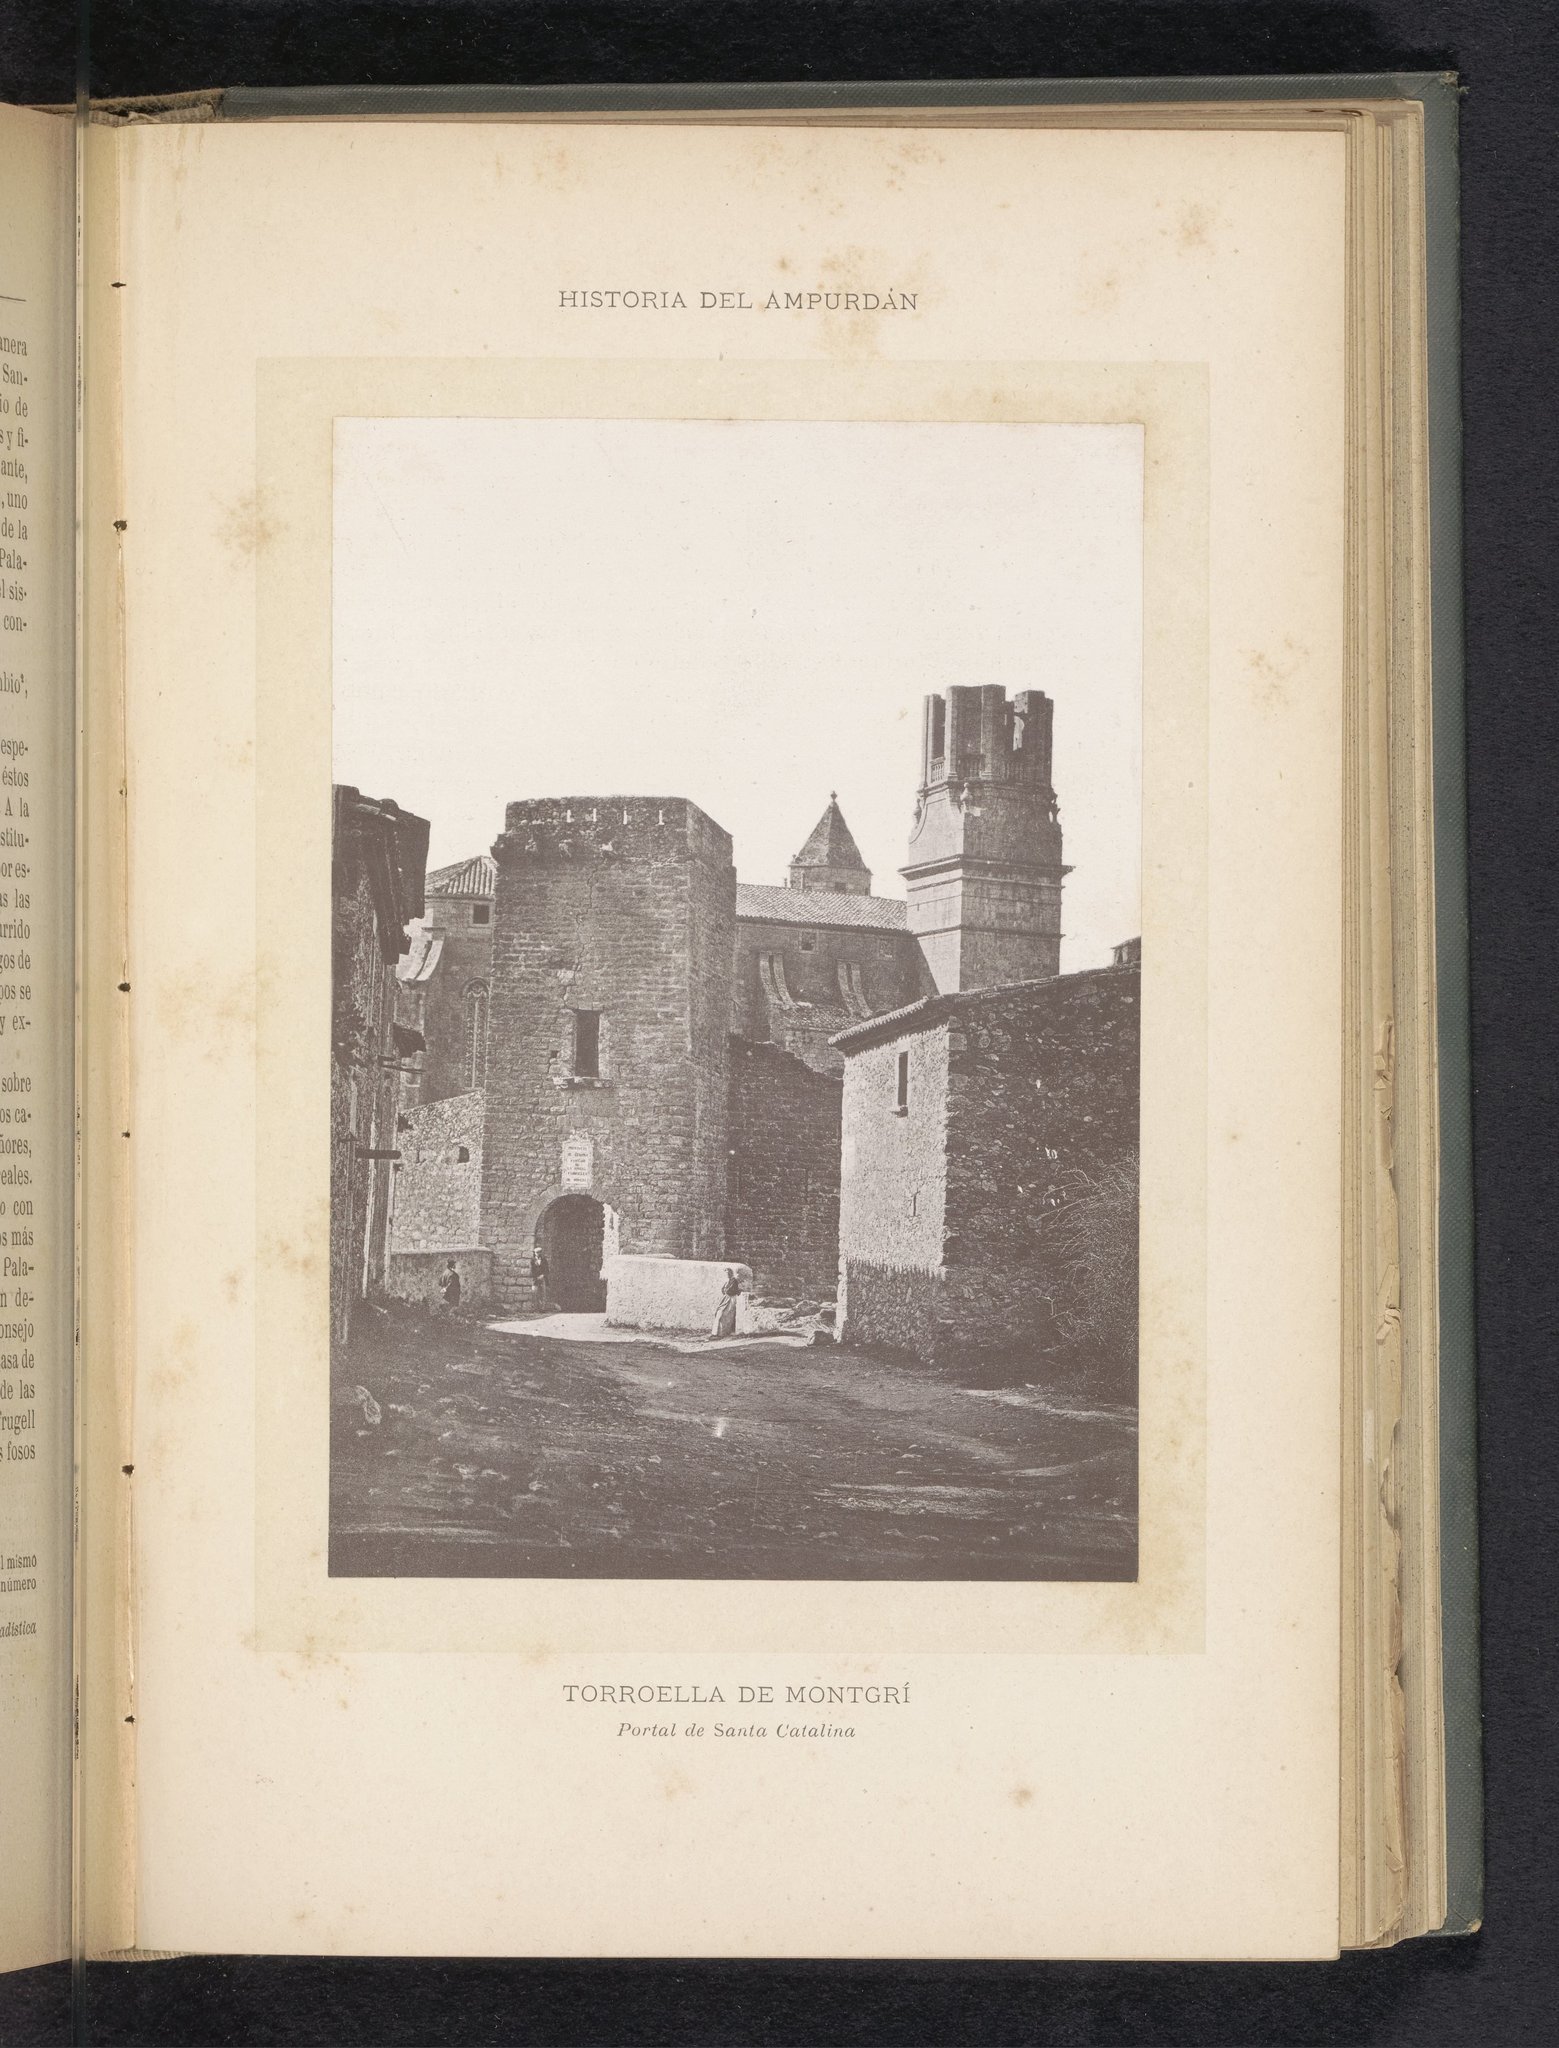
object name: photomechanical print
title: Santa Catalinapoort te Torroella de Montgrí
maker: Anonymous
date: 1873-1883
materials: paper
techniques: photograph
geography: torroella de montgrí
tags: gate, entrance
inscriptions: inscription: ‘Portal de Santa Catalina’